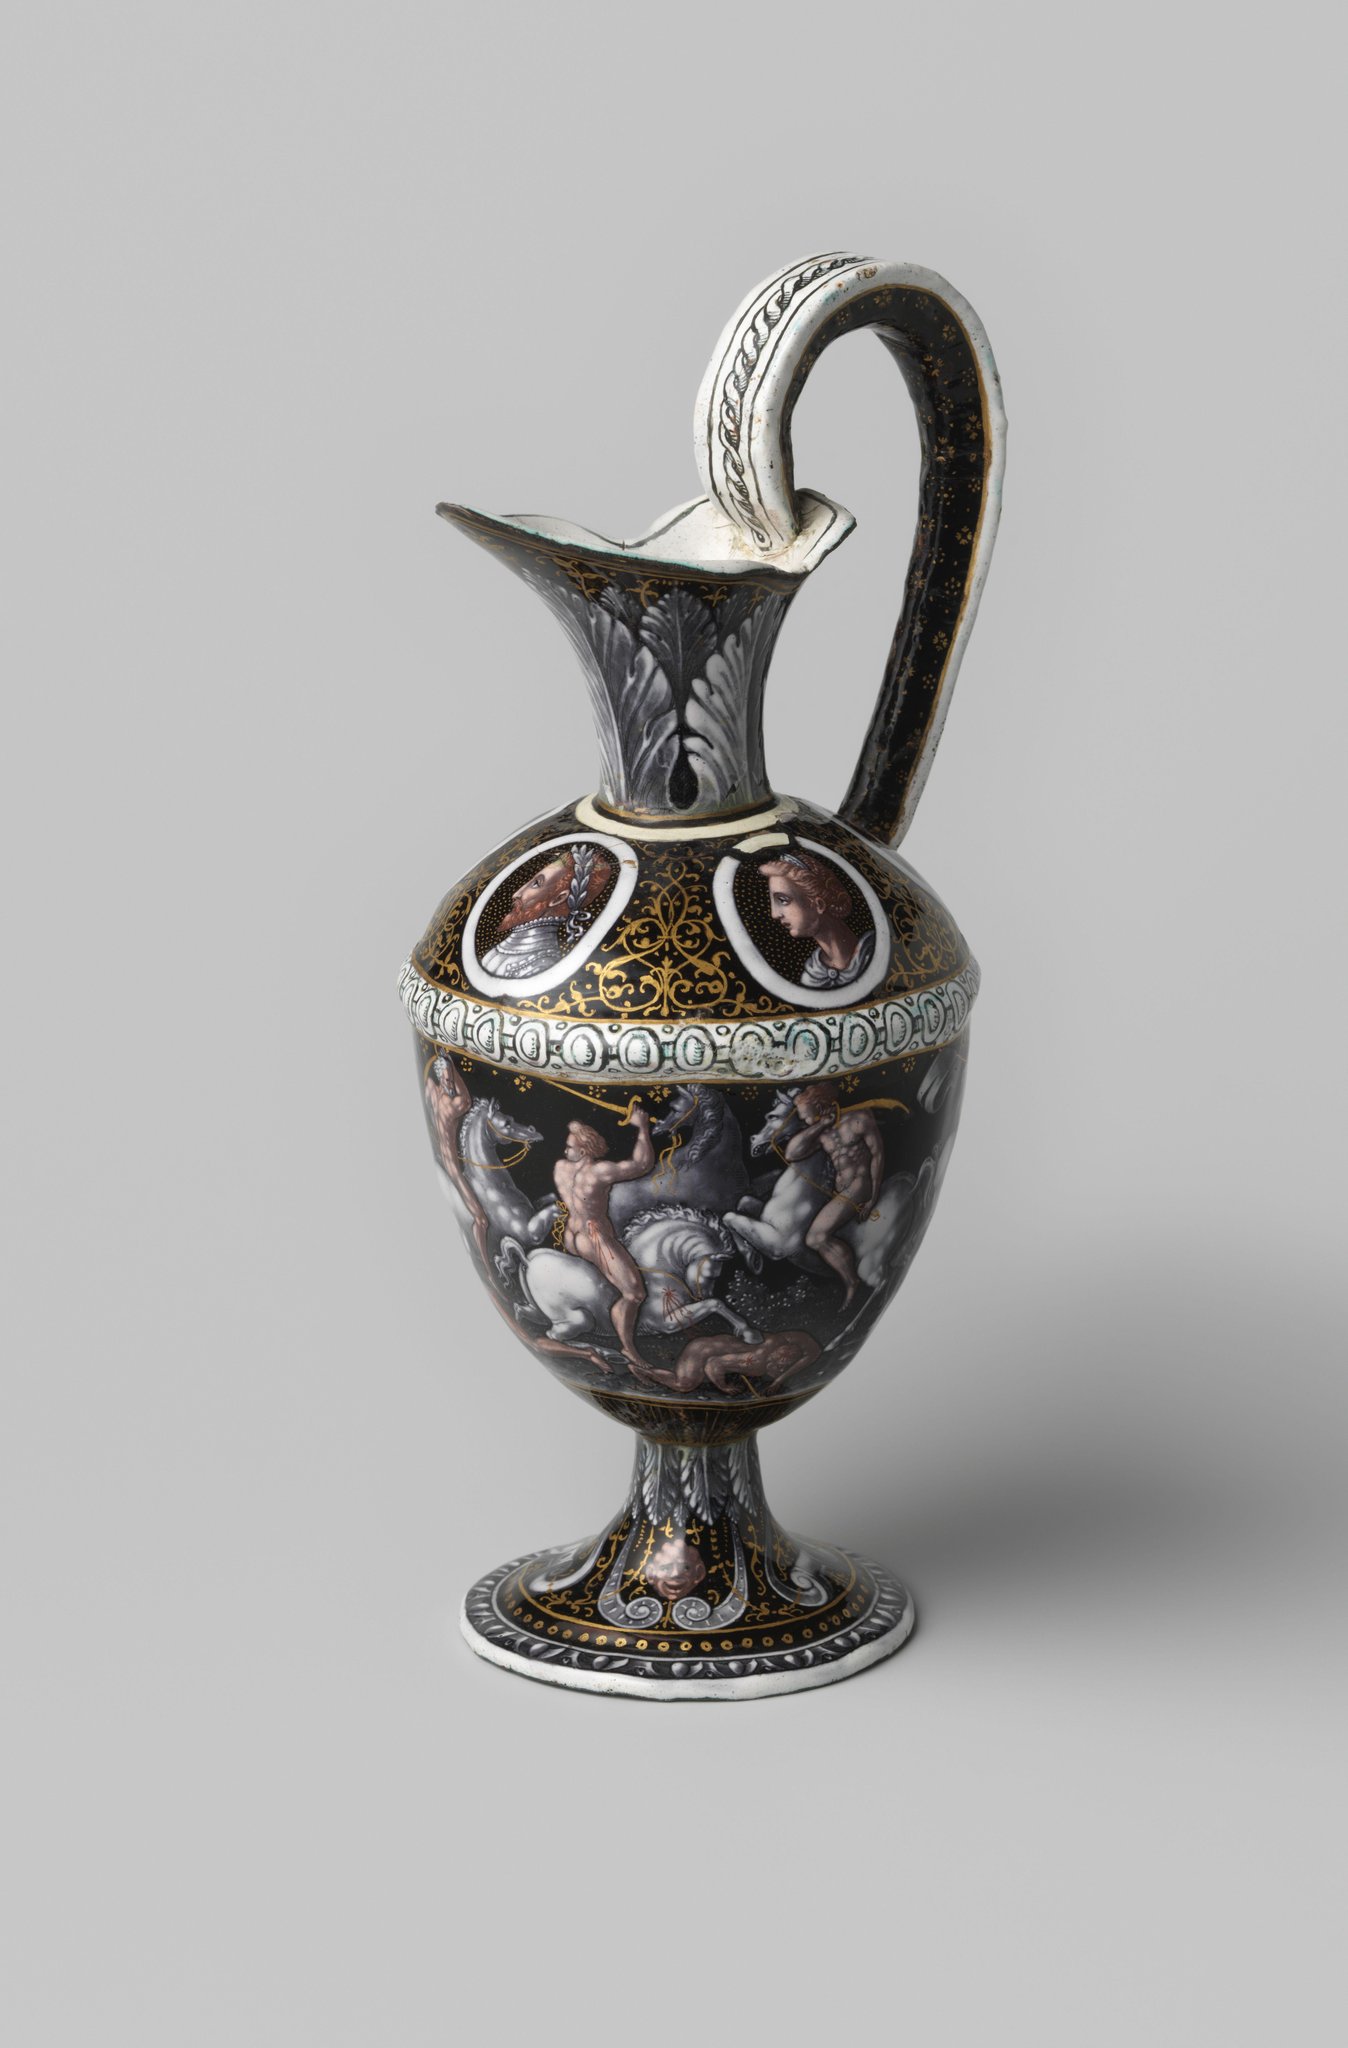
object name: ewer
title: Kan met voorstelling van een ruitergevecht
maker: jean court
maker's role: emailleschilder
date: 1560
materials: copper, gold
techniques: gilding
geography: limoges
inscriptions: monogram: ‘I.C.’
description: Ewer with an equestrian battle and portrait medallions. C. 1560, by Jean Court.